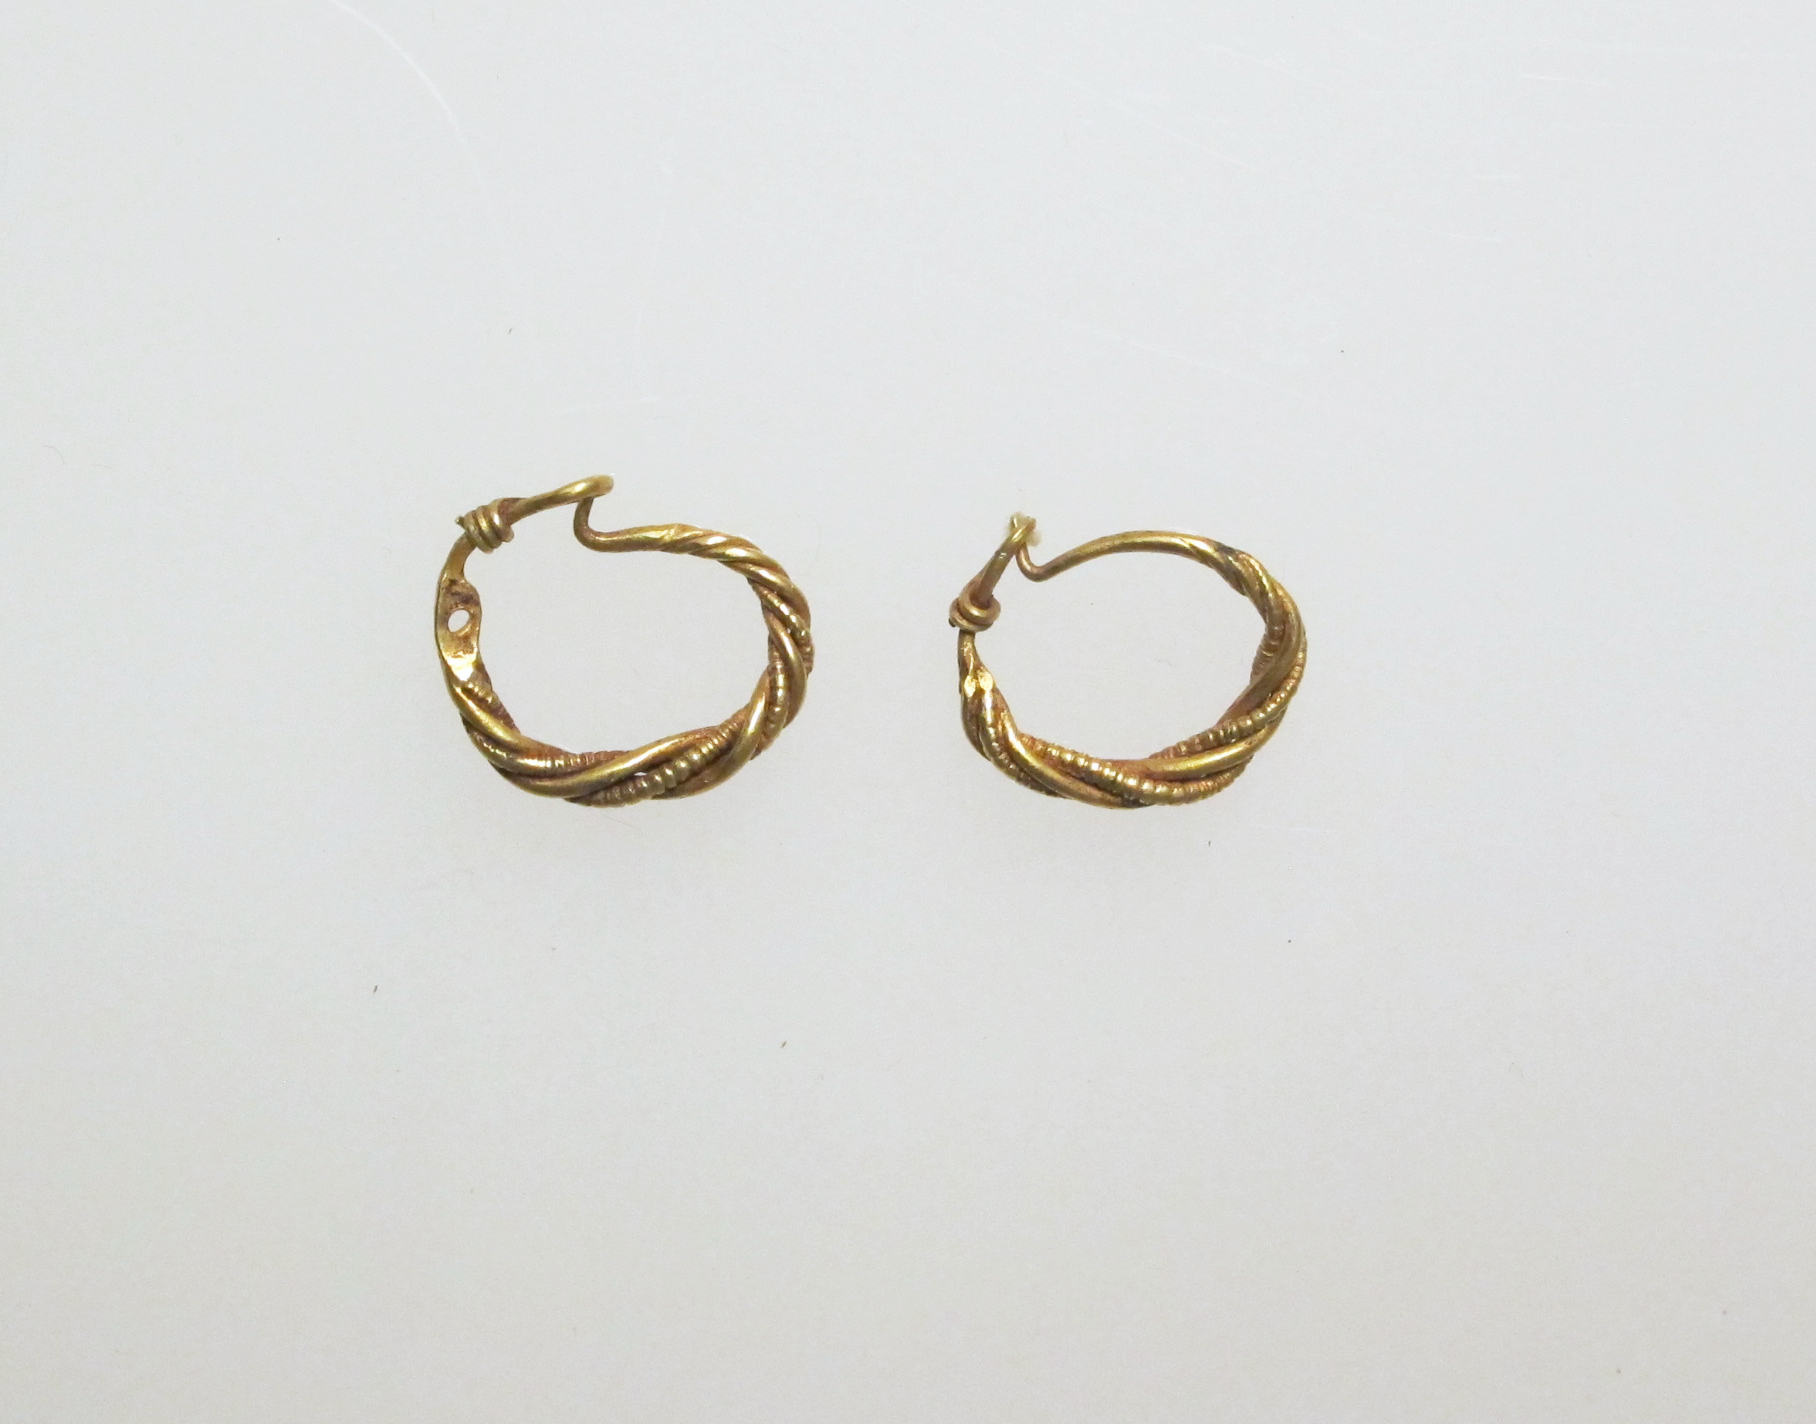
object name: earring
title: Earrings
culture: greek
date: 7000-30 BCE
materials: gold